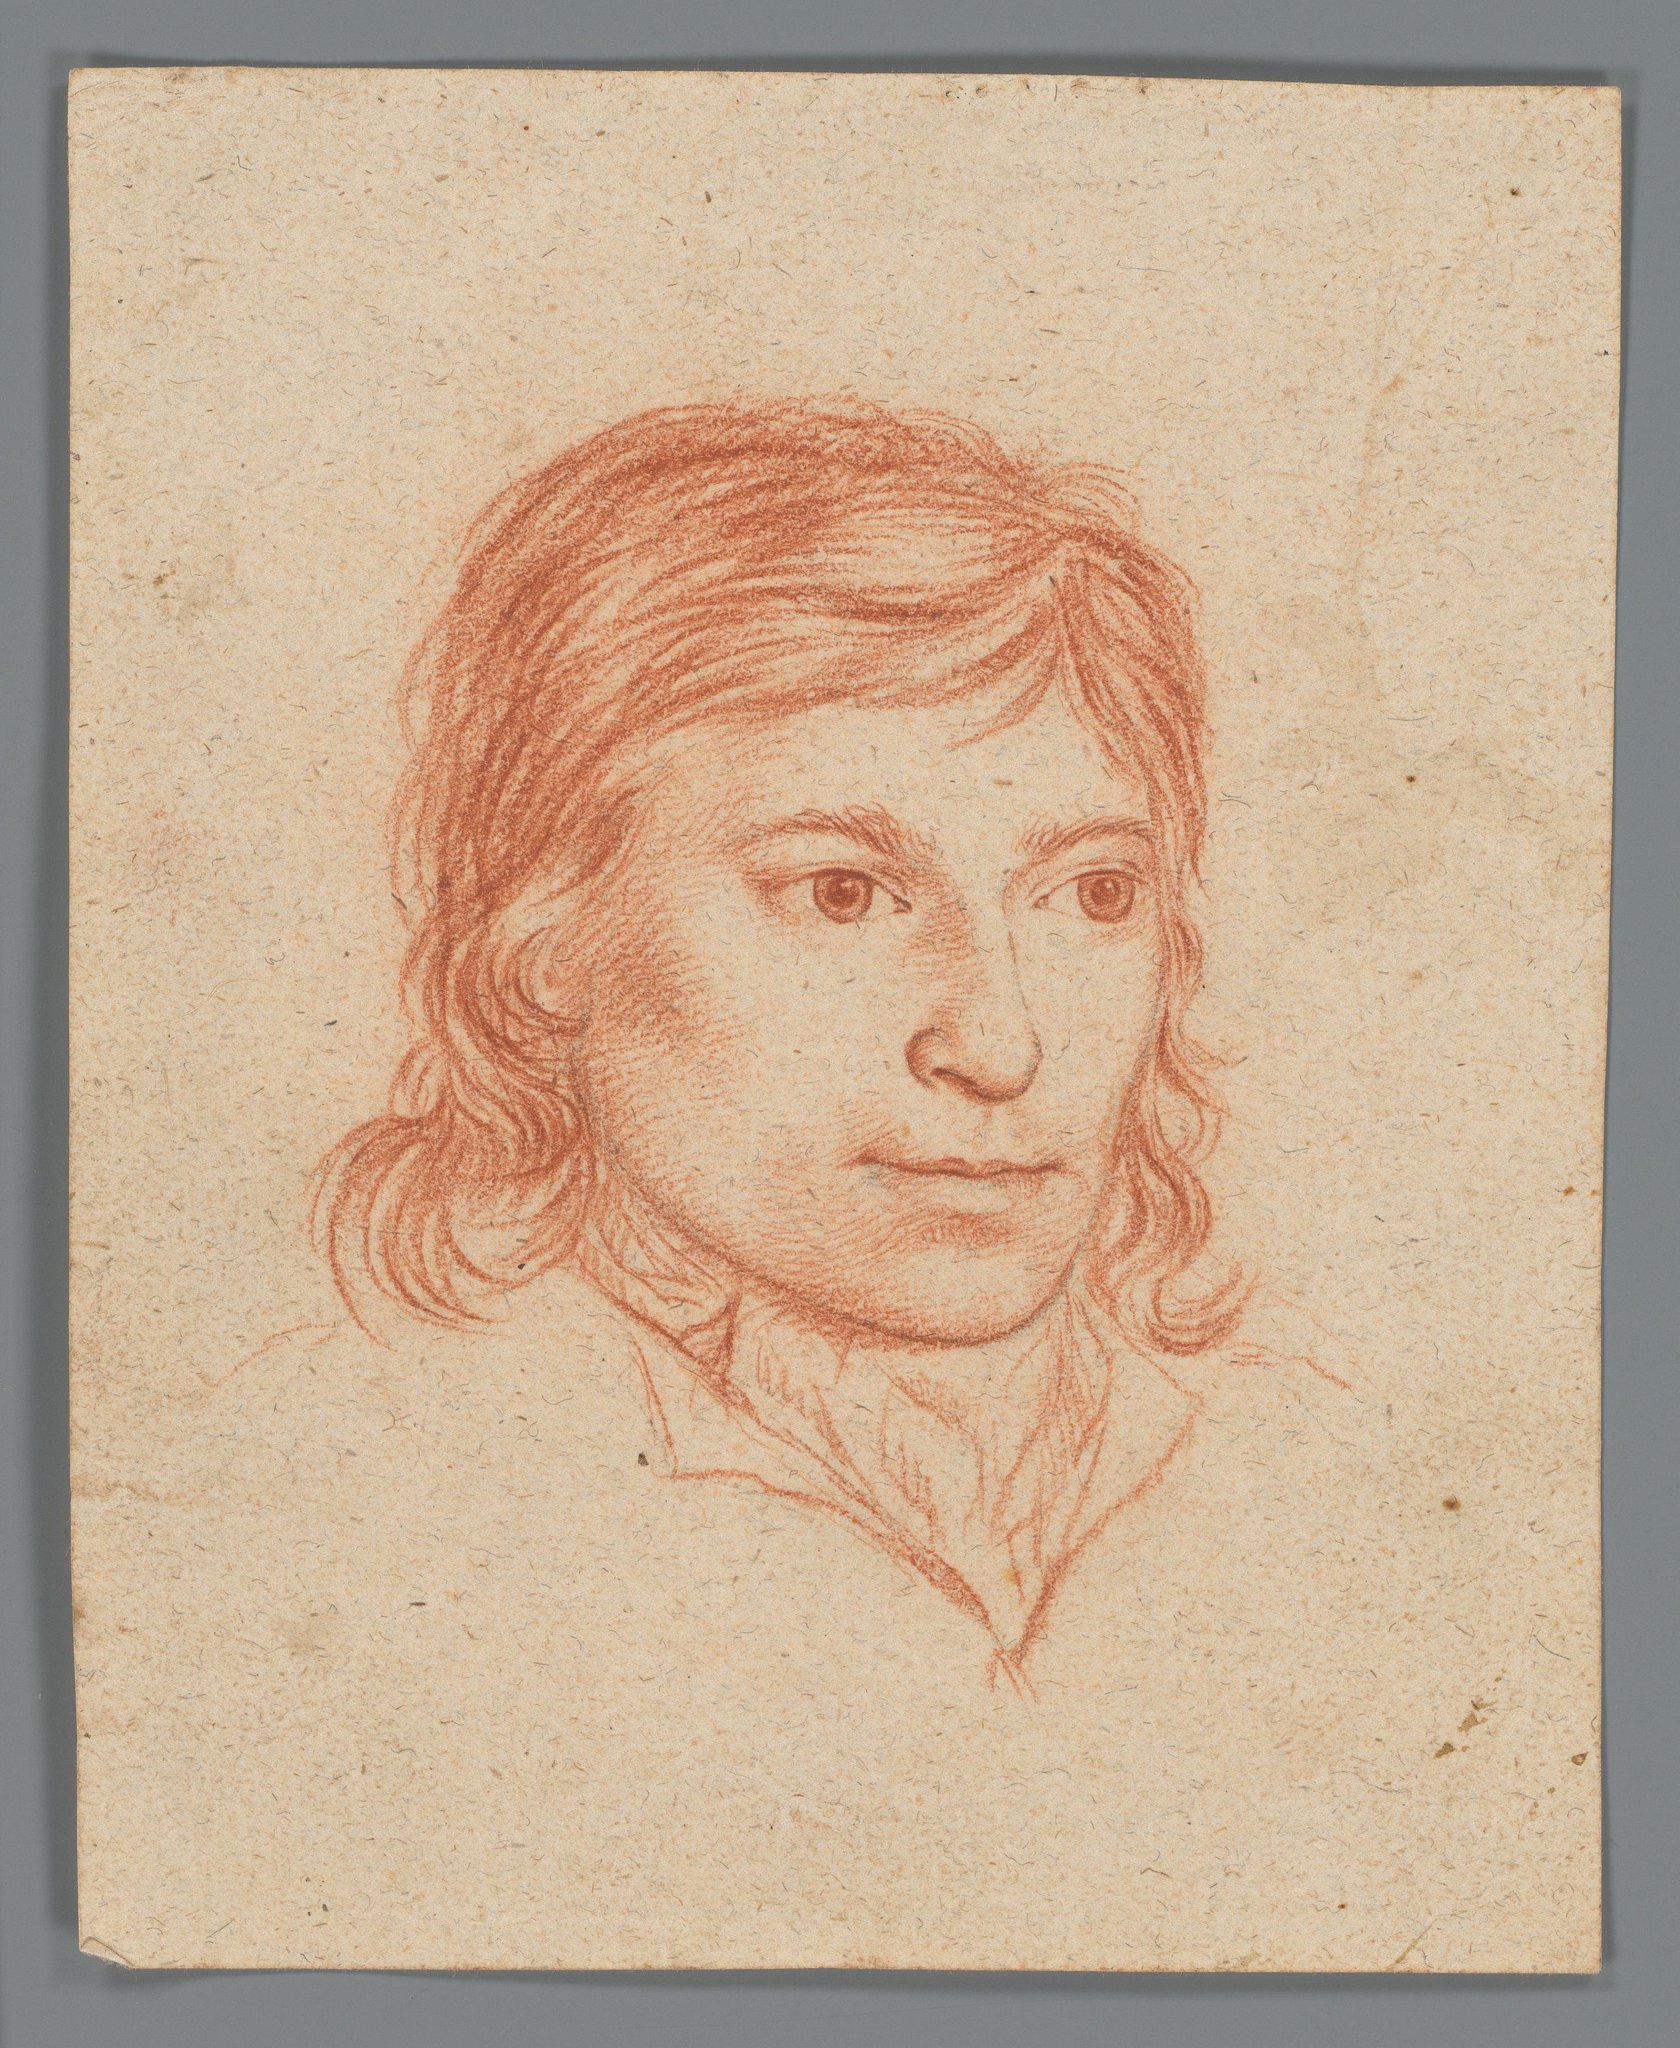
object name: drawing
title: Portret van een jonge man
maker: matthijs balen (1684-1766)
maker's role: draughtsman, painter, print maker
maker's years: 1684-1766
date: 1694-1766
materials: chalk, paper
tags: youth, adolescent